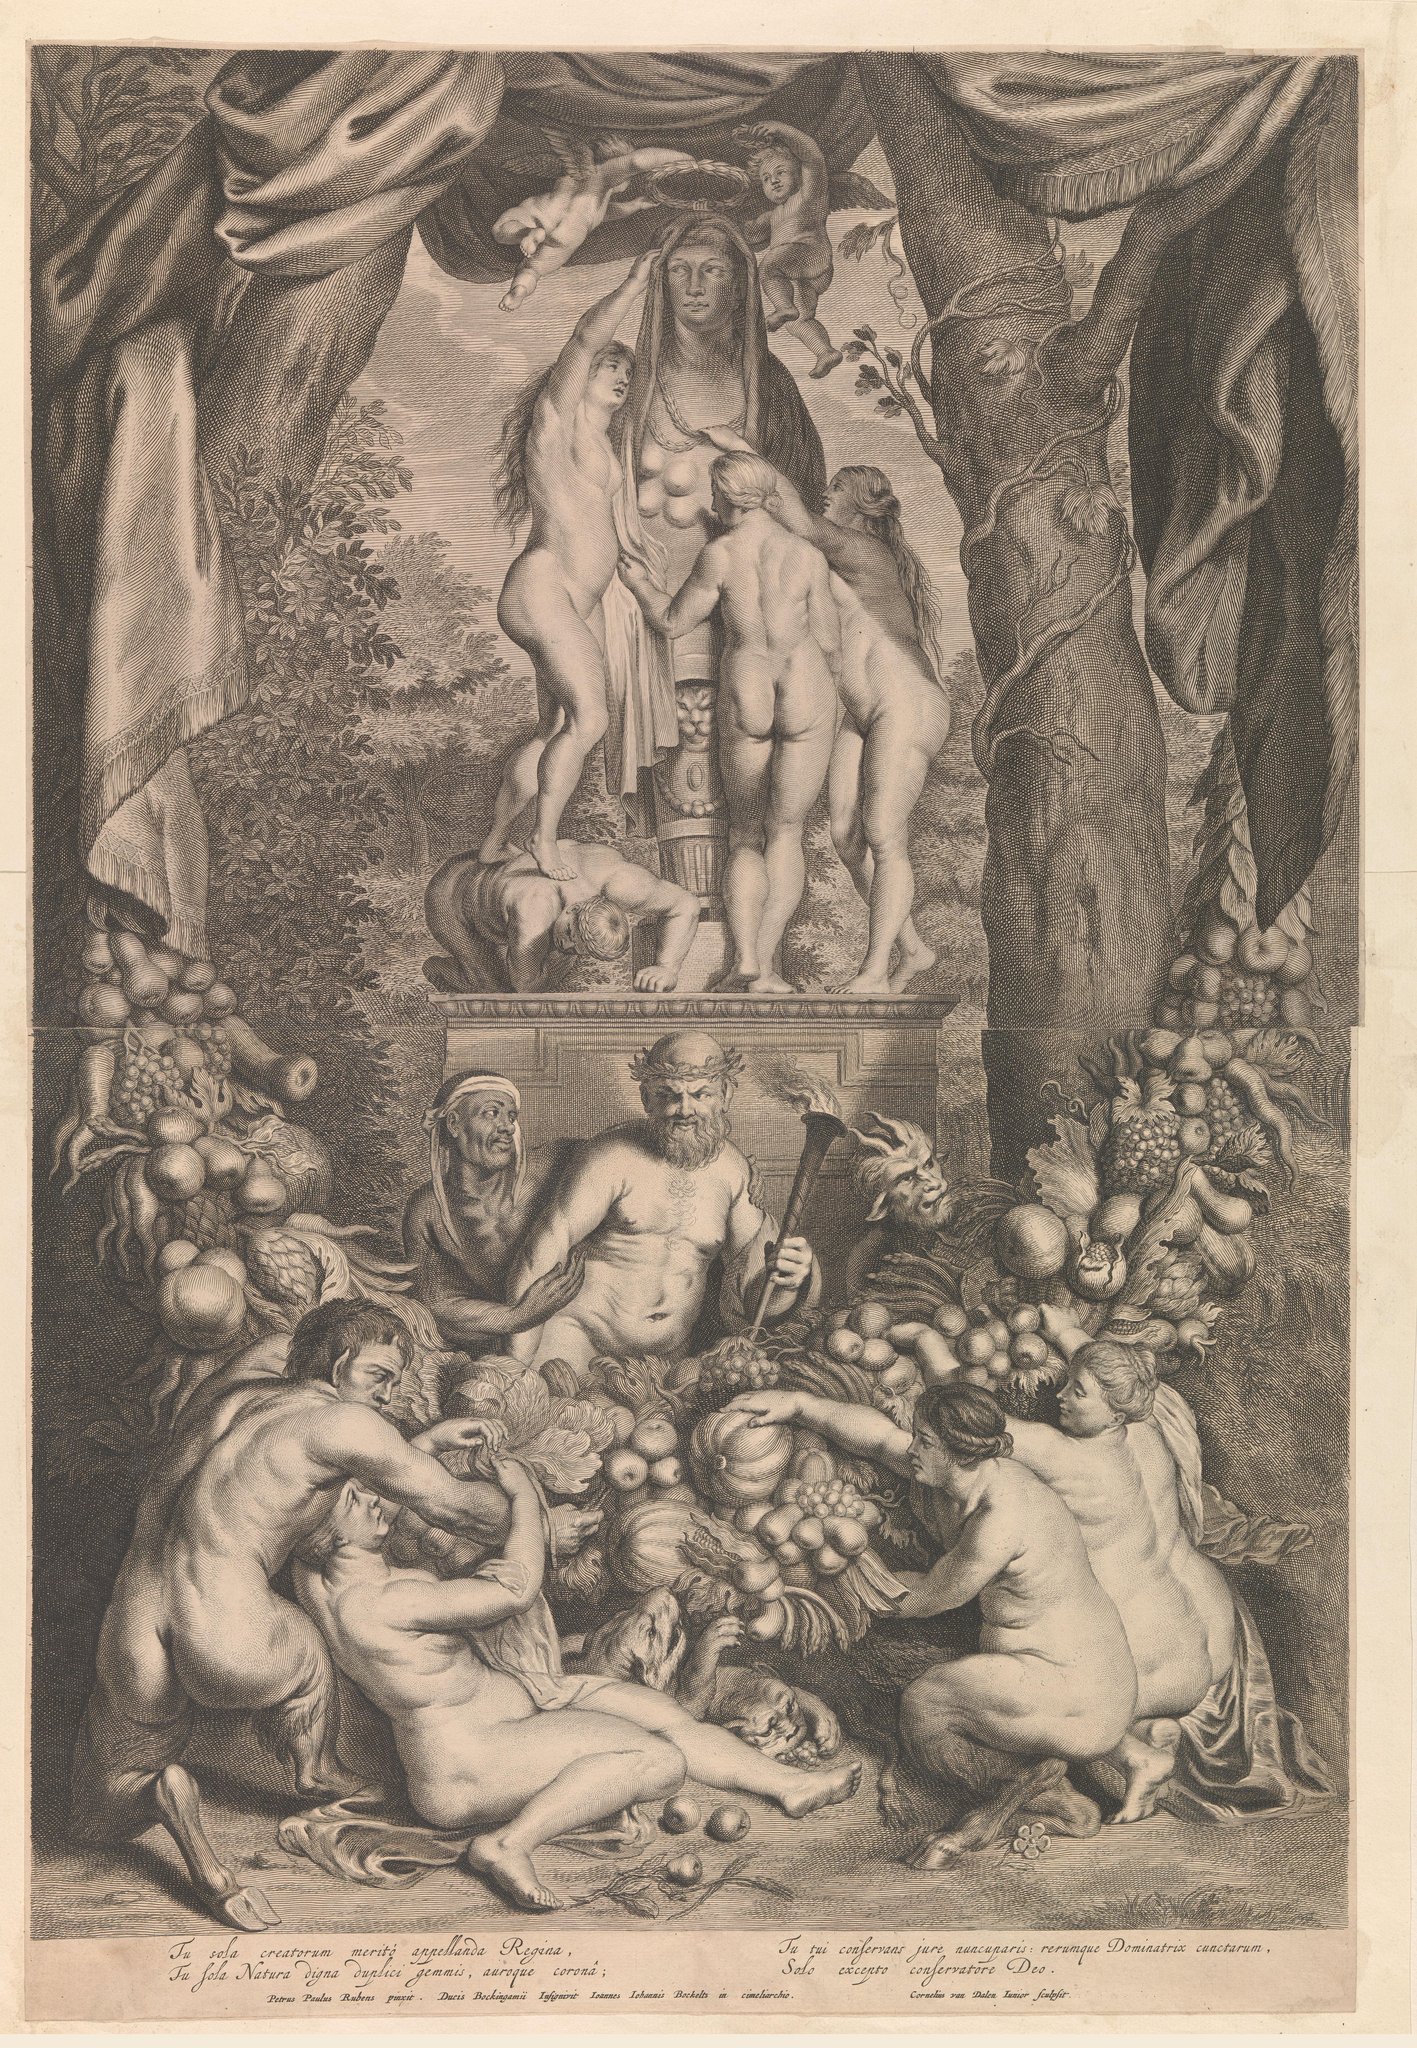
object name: album leaf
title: Allegorie op de Natuur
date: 1648-1664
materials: paper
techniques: engraving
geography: amsterdam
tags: 'natura' (allegorical figure or scene; or as diana of ephesus, with many breasts); 'natura' (ripa), satyr(s) (in general) - ll - female satyrs (in general), satyr(s) (in general)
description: Allegorie op de Natuur met nimfen die buste eren van Diana met vele borsten. Voor de sokkel van het beeld zitten Bacchus, nimfen en vrouwelijke en mannelijke saters die groenten en fruit plukken van een grote guirlande waarvan ook dieren eten. Twee bladen aan elkaar geplakt. Deze prent maakt deel uit van een album.